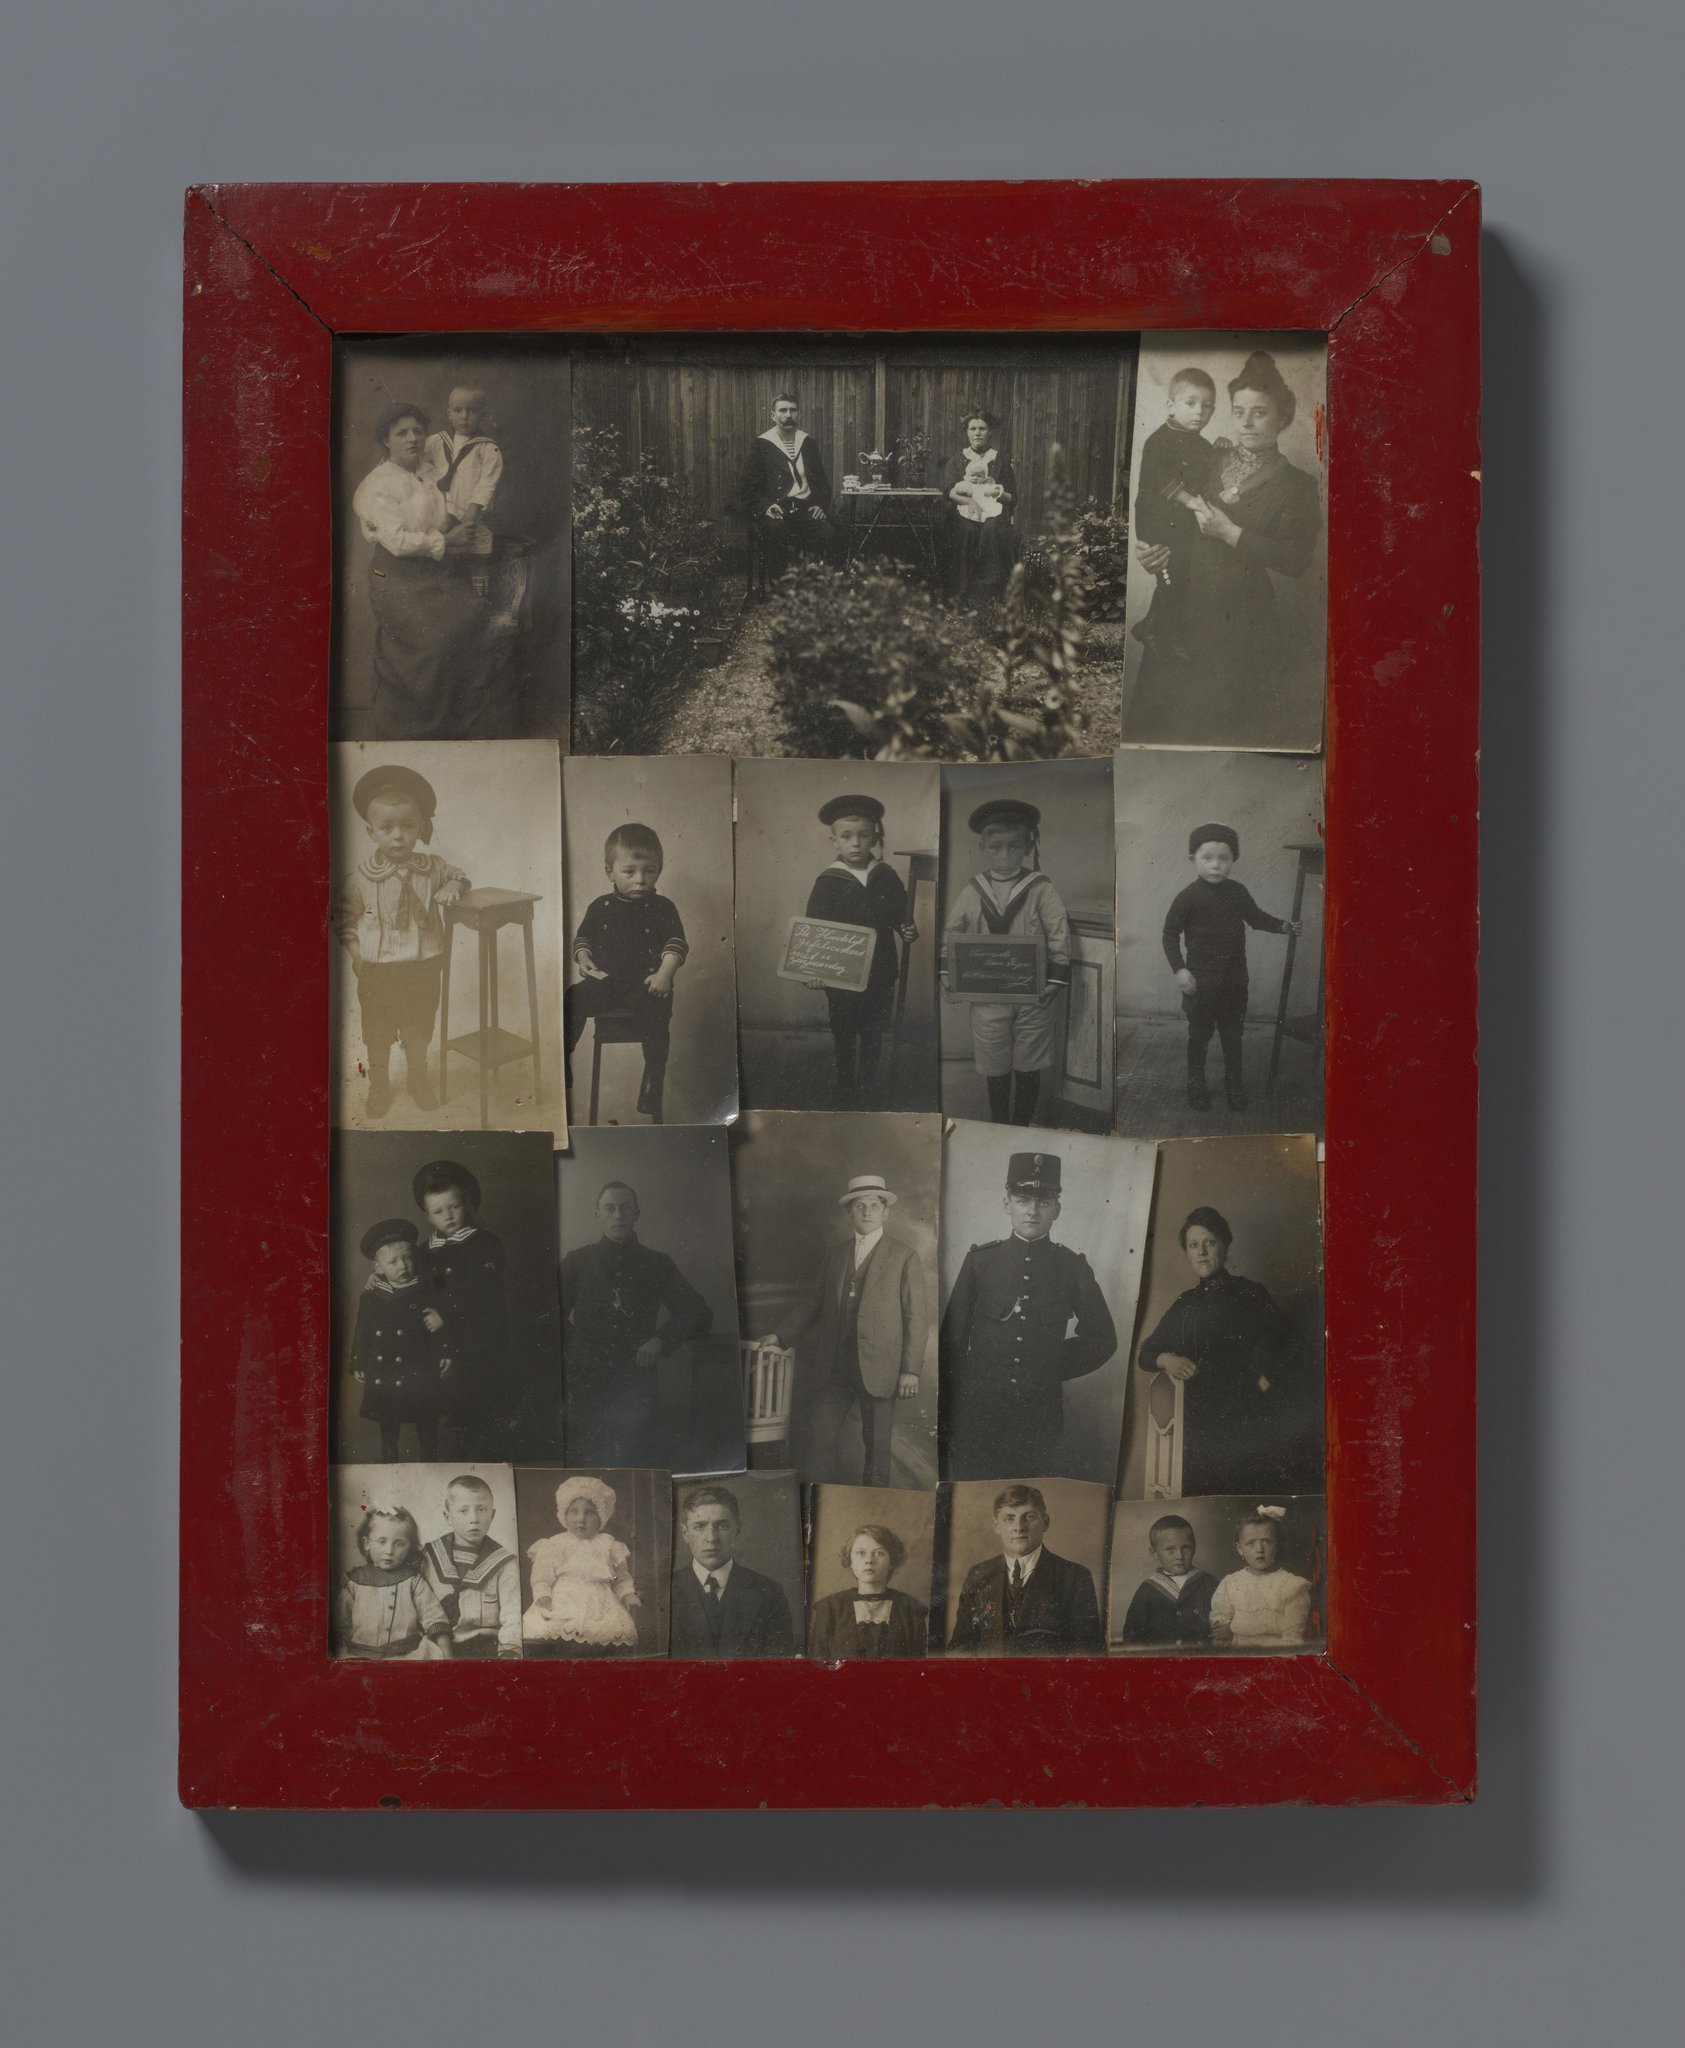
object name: frame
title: Negentien foto's van een onbekend gezin met jonge kinderen, waaronder snelfoto's, studioportretten en een foto in een tuin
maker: Anonymous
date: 1910-1925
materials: paper, cardboard, glass, metal, pressure sensitive tape, textile, wood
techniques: gelatin silver print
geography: netherlands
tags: family group, especially parents with their child(ren), tot, toddler ~ the ages of man, historical persons not known by name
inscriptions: number: ‘8’